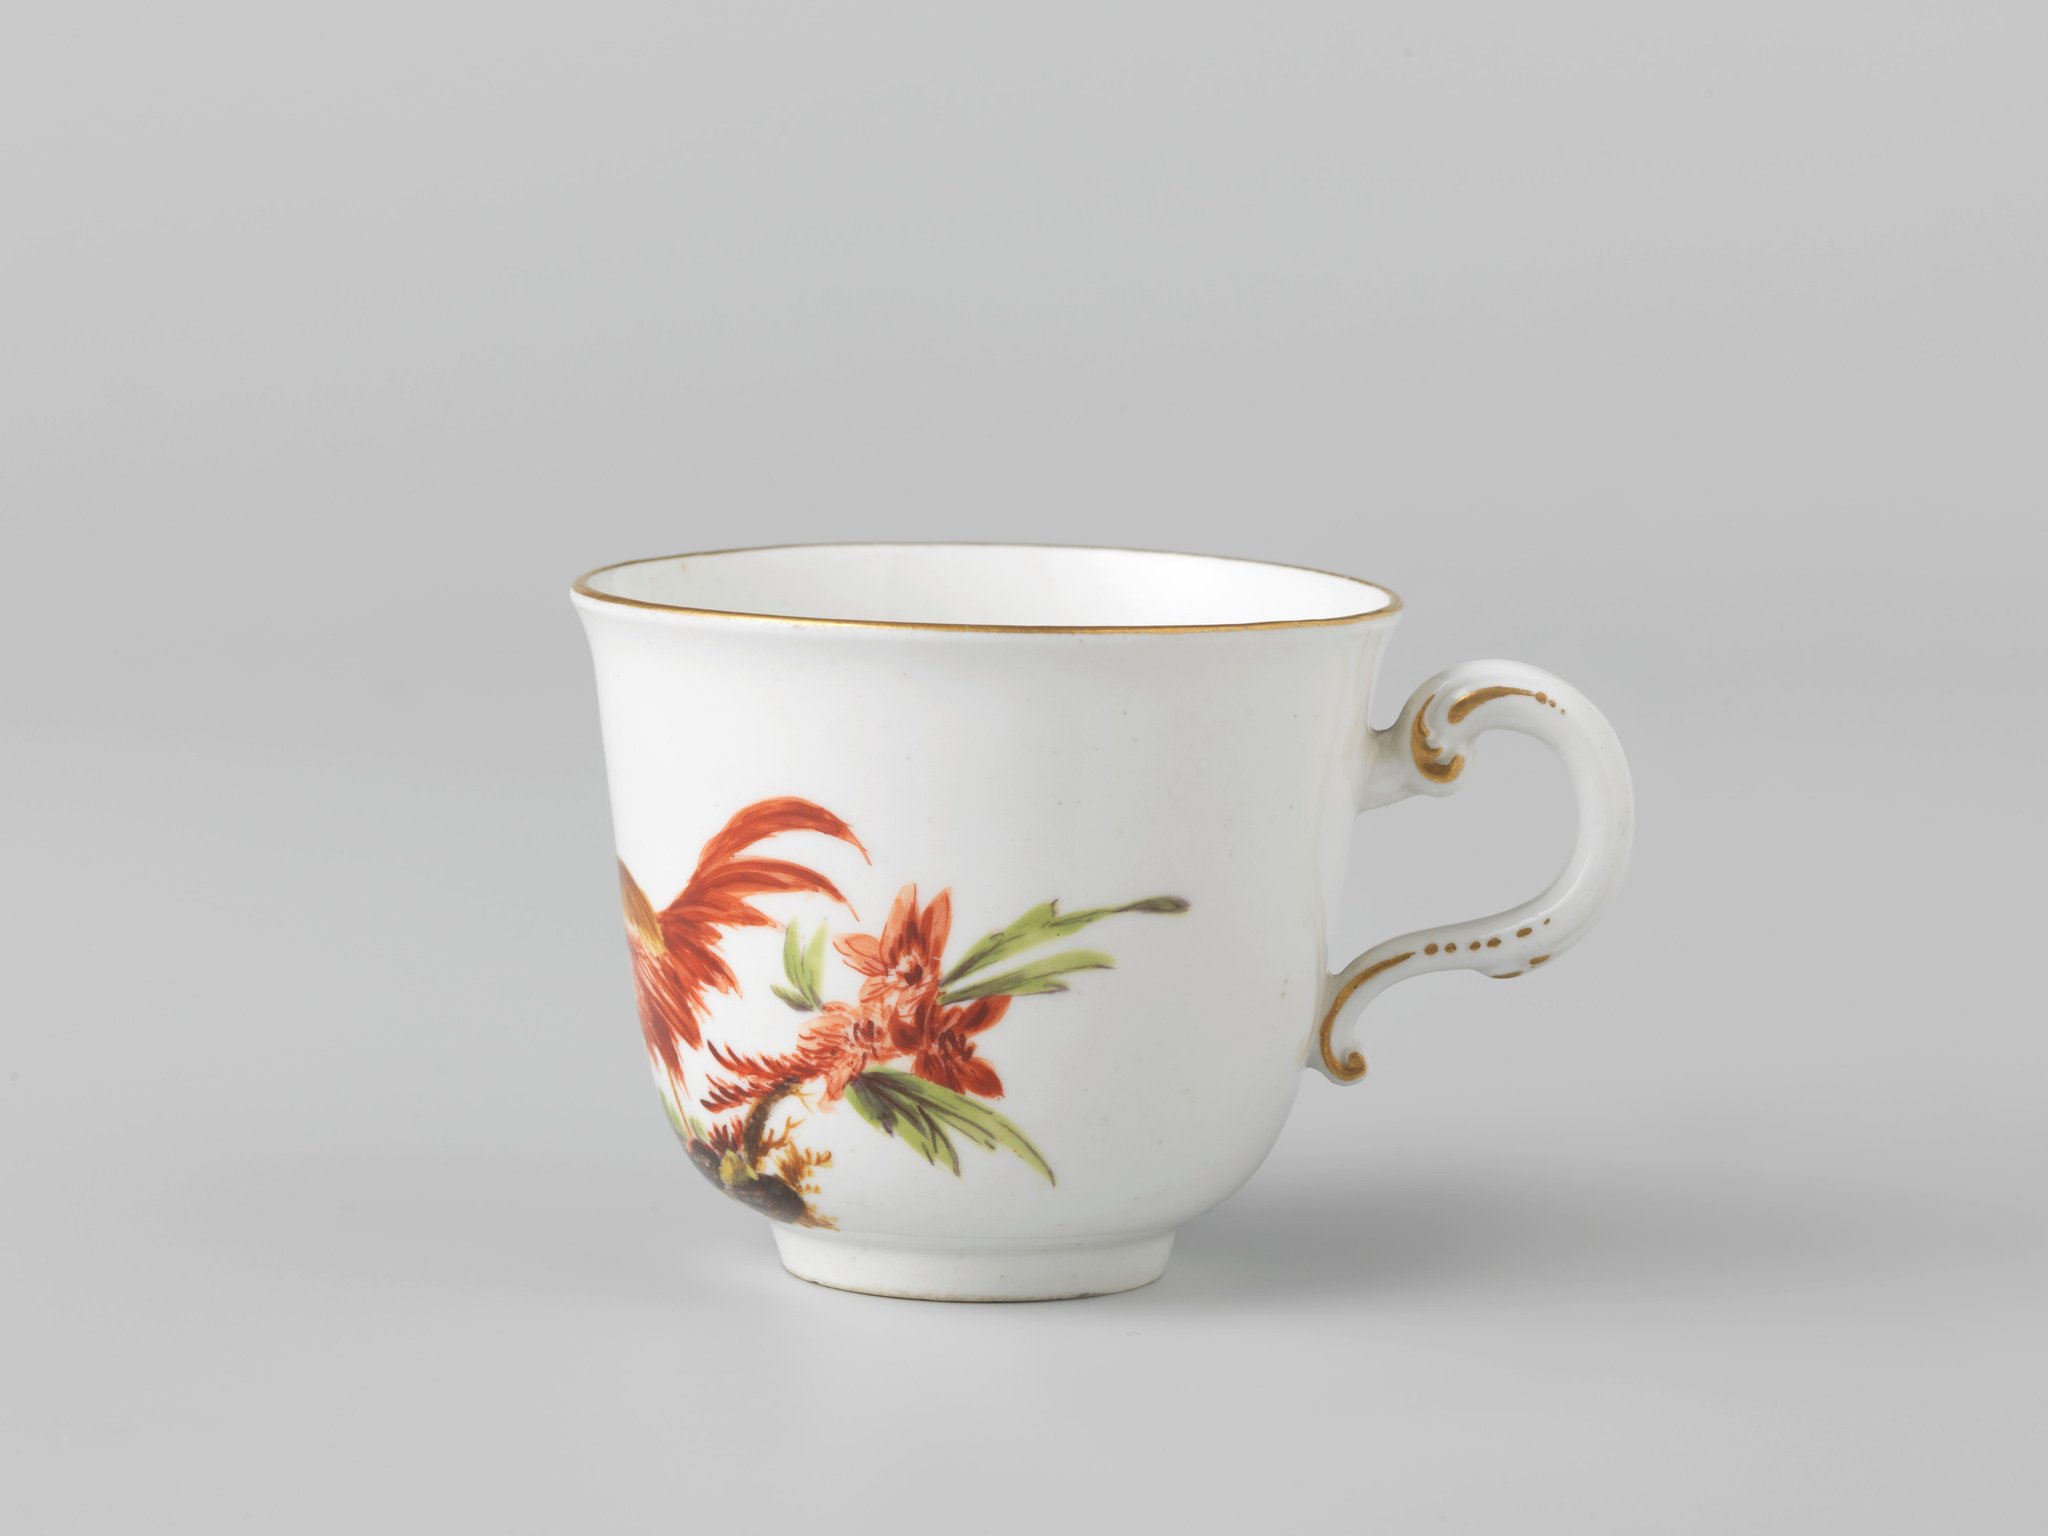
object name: cup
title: Kop, beschilderd met hoenders en planten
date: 1774-1778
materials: porcelain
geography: loosdrecht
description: Coffee cup and saucer. Porcelain. Loosdrecht, c. 1774-1778. Factory of Joannes de Mol.